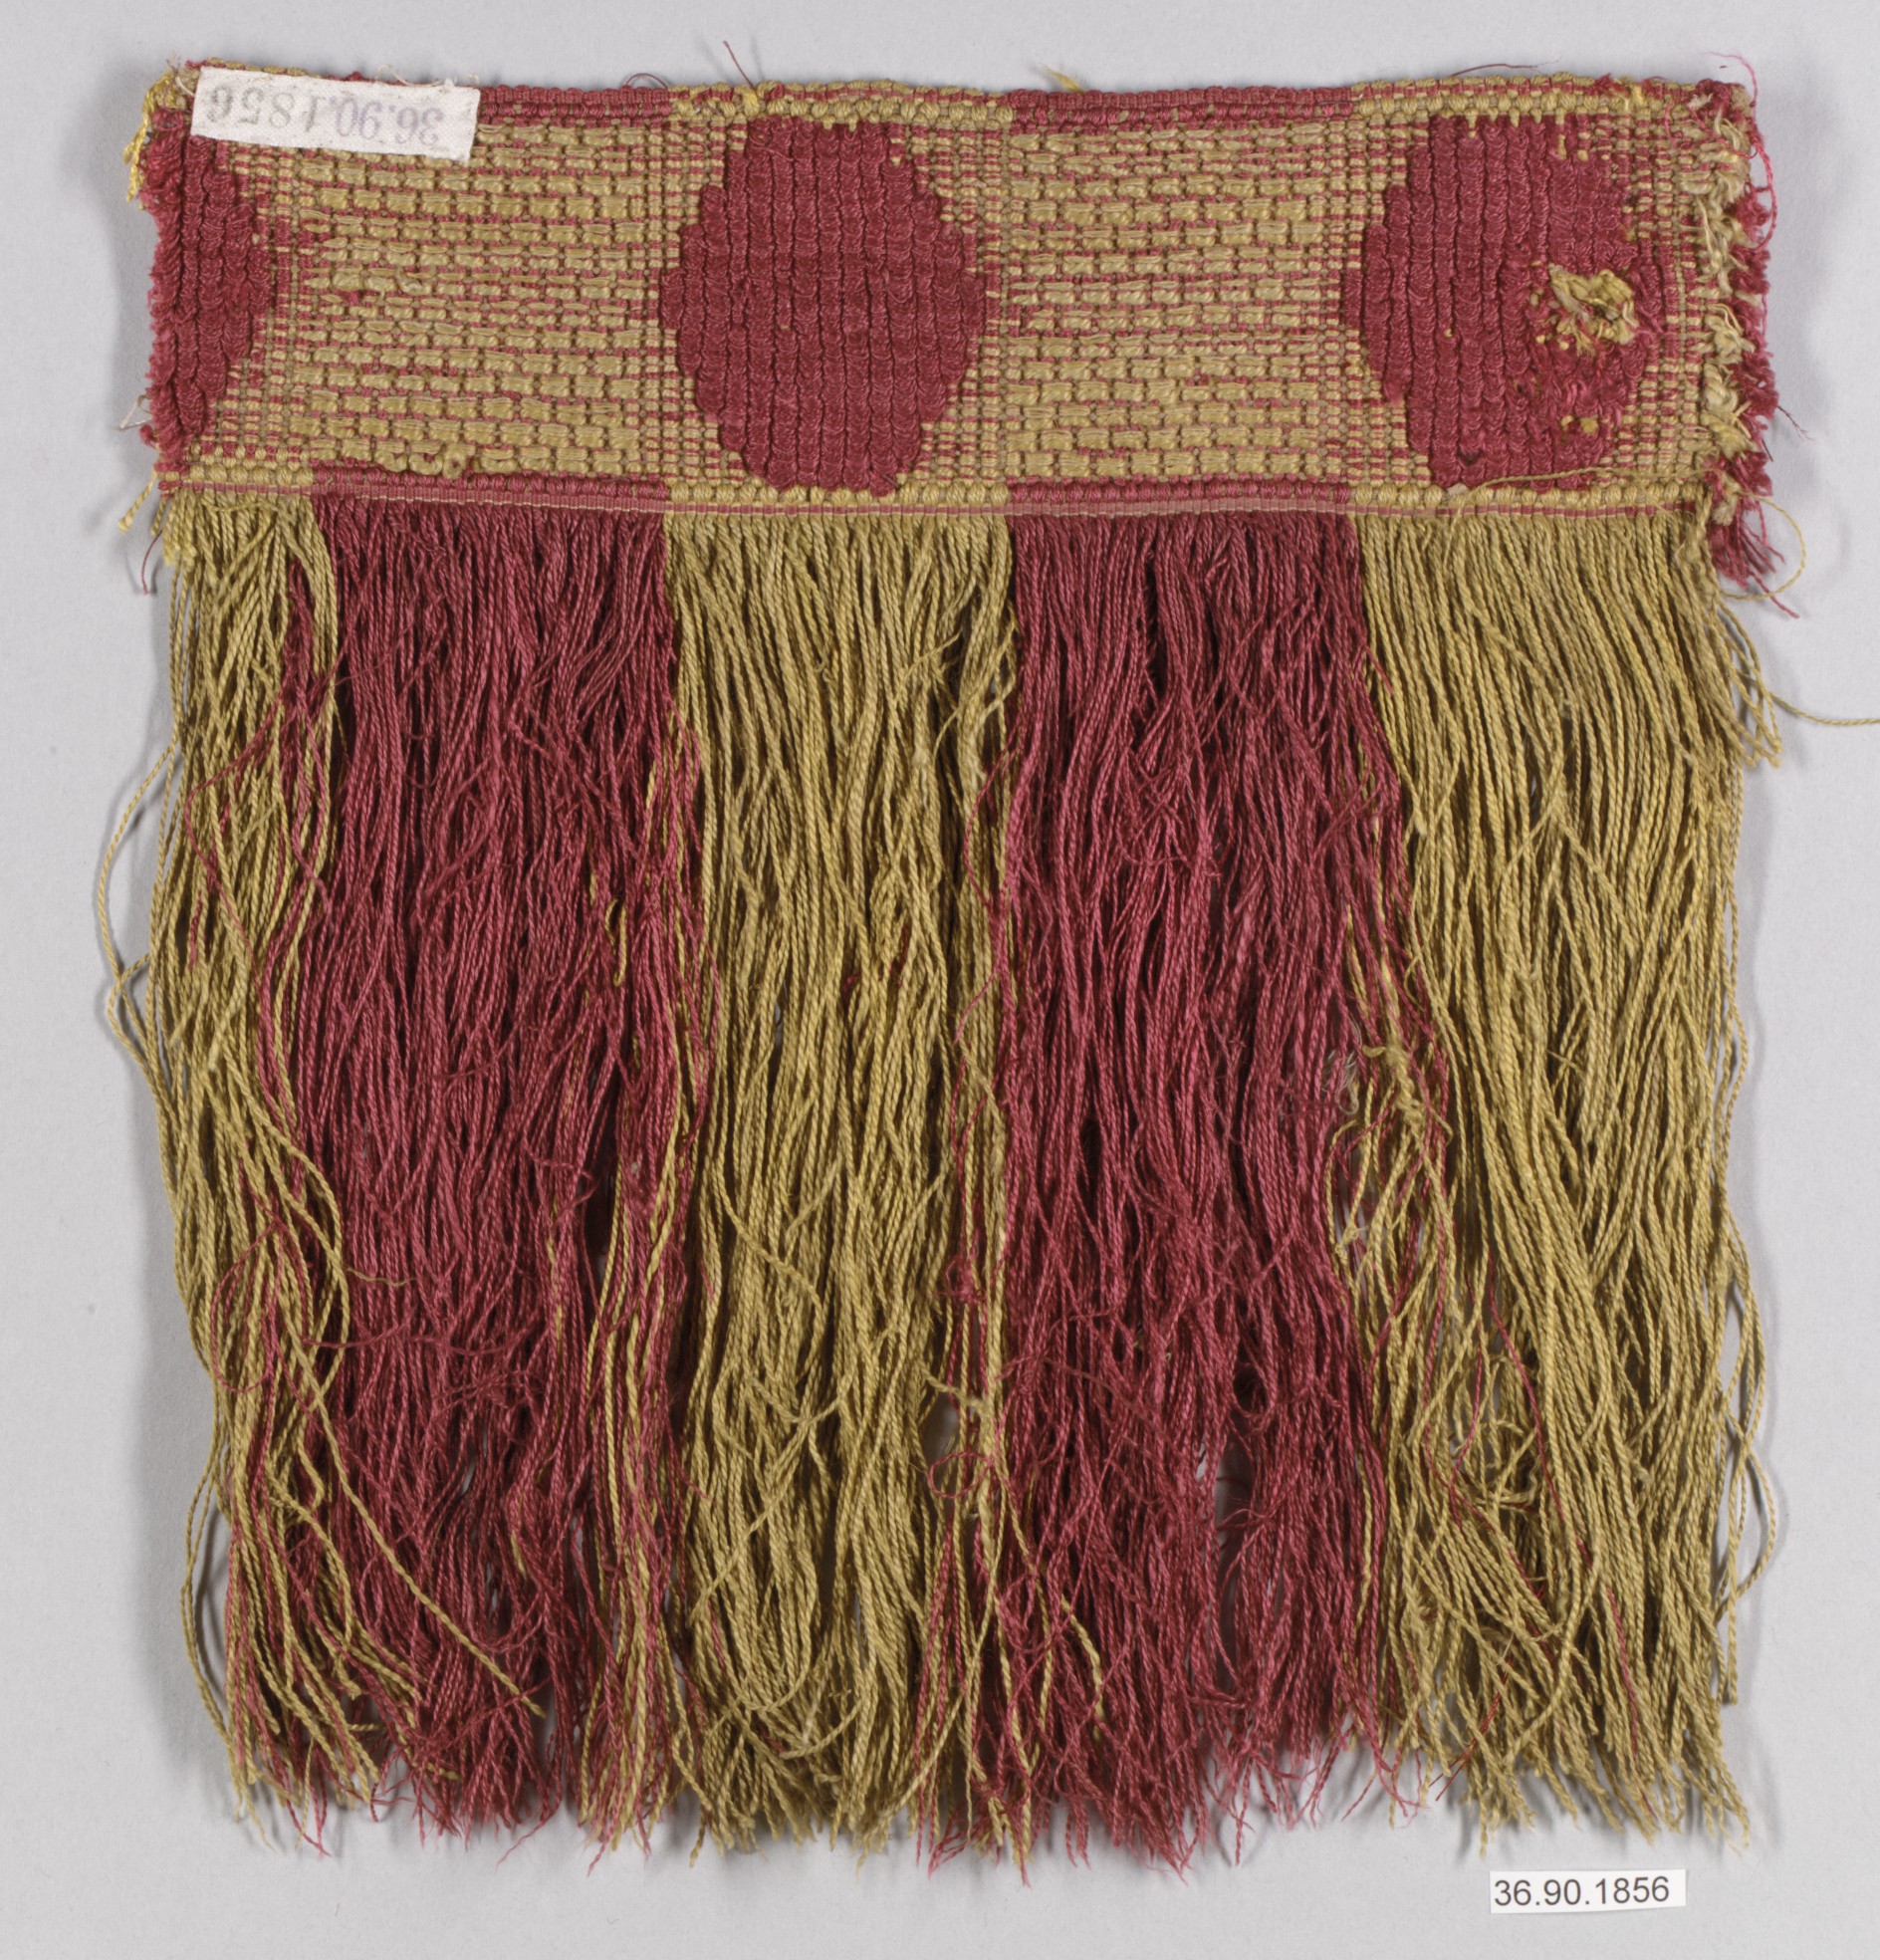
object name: fringe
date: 1834-1866